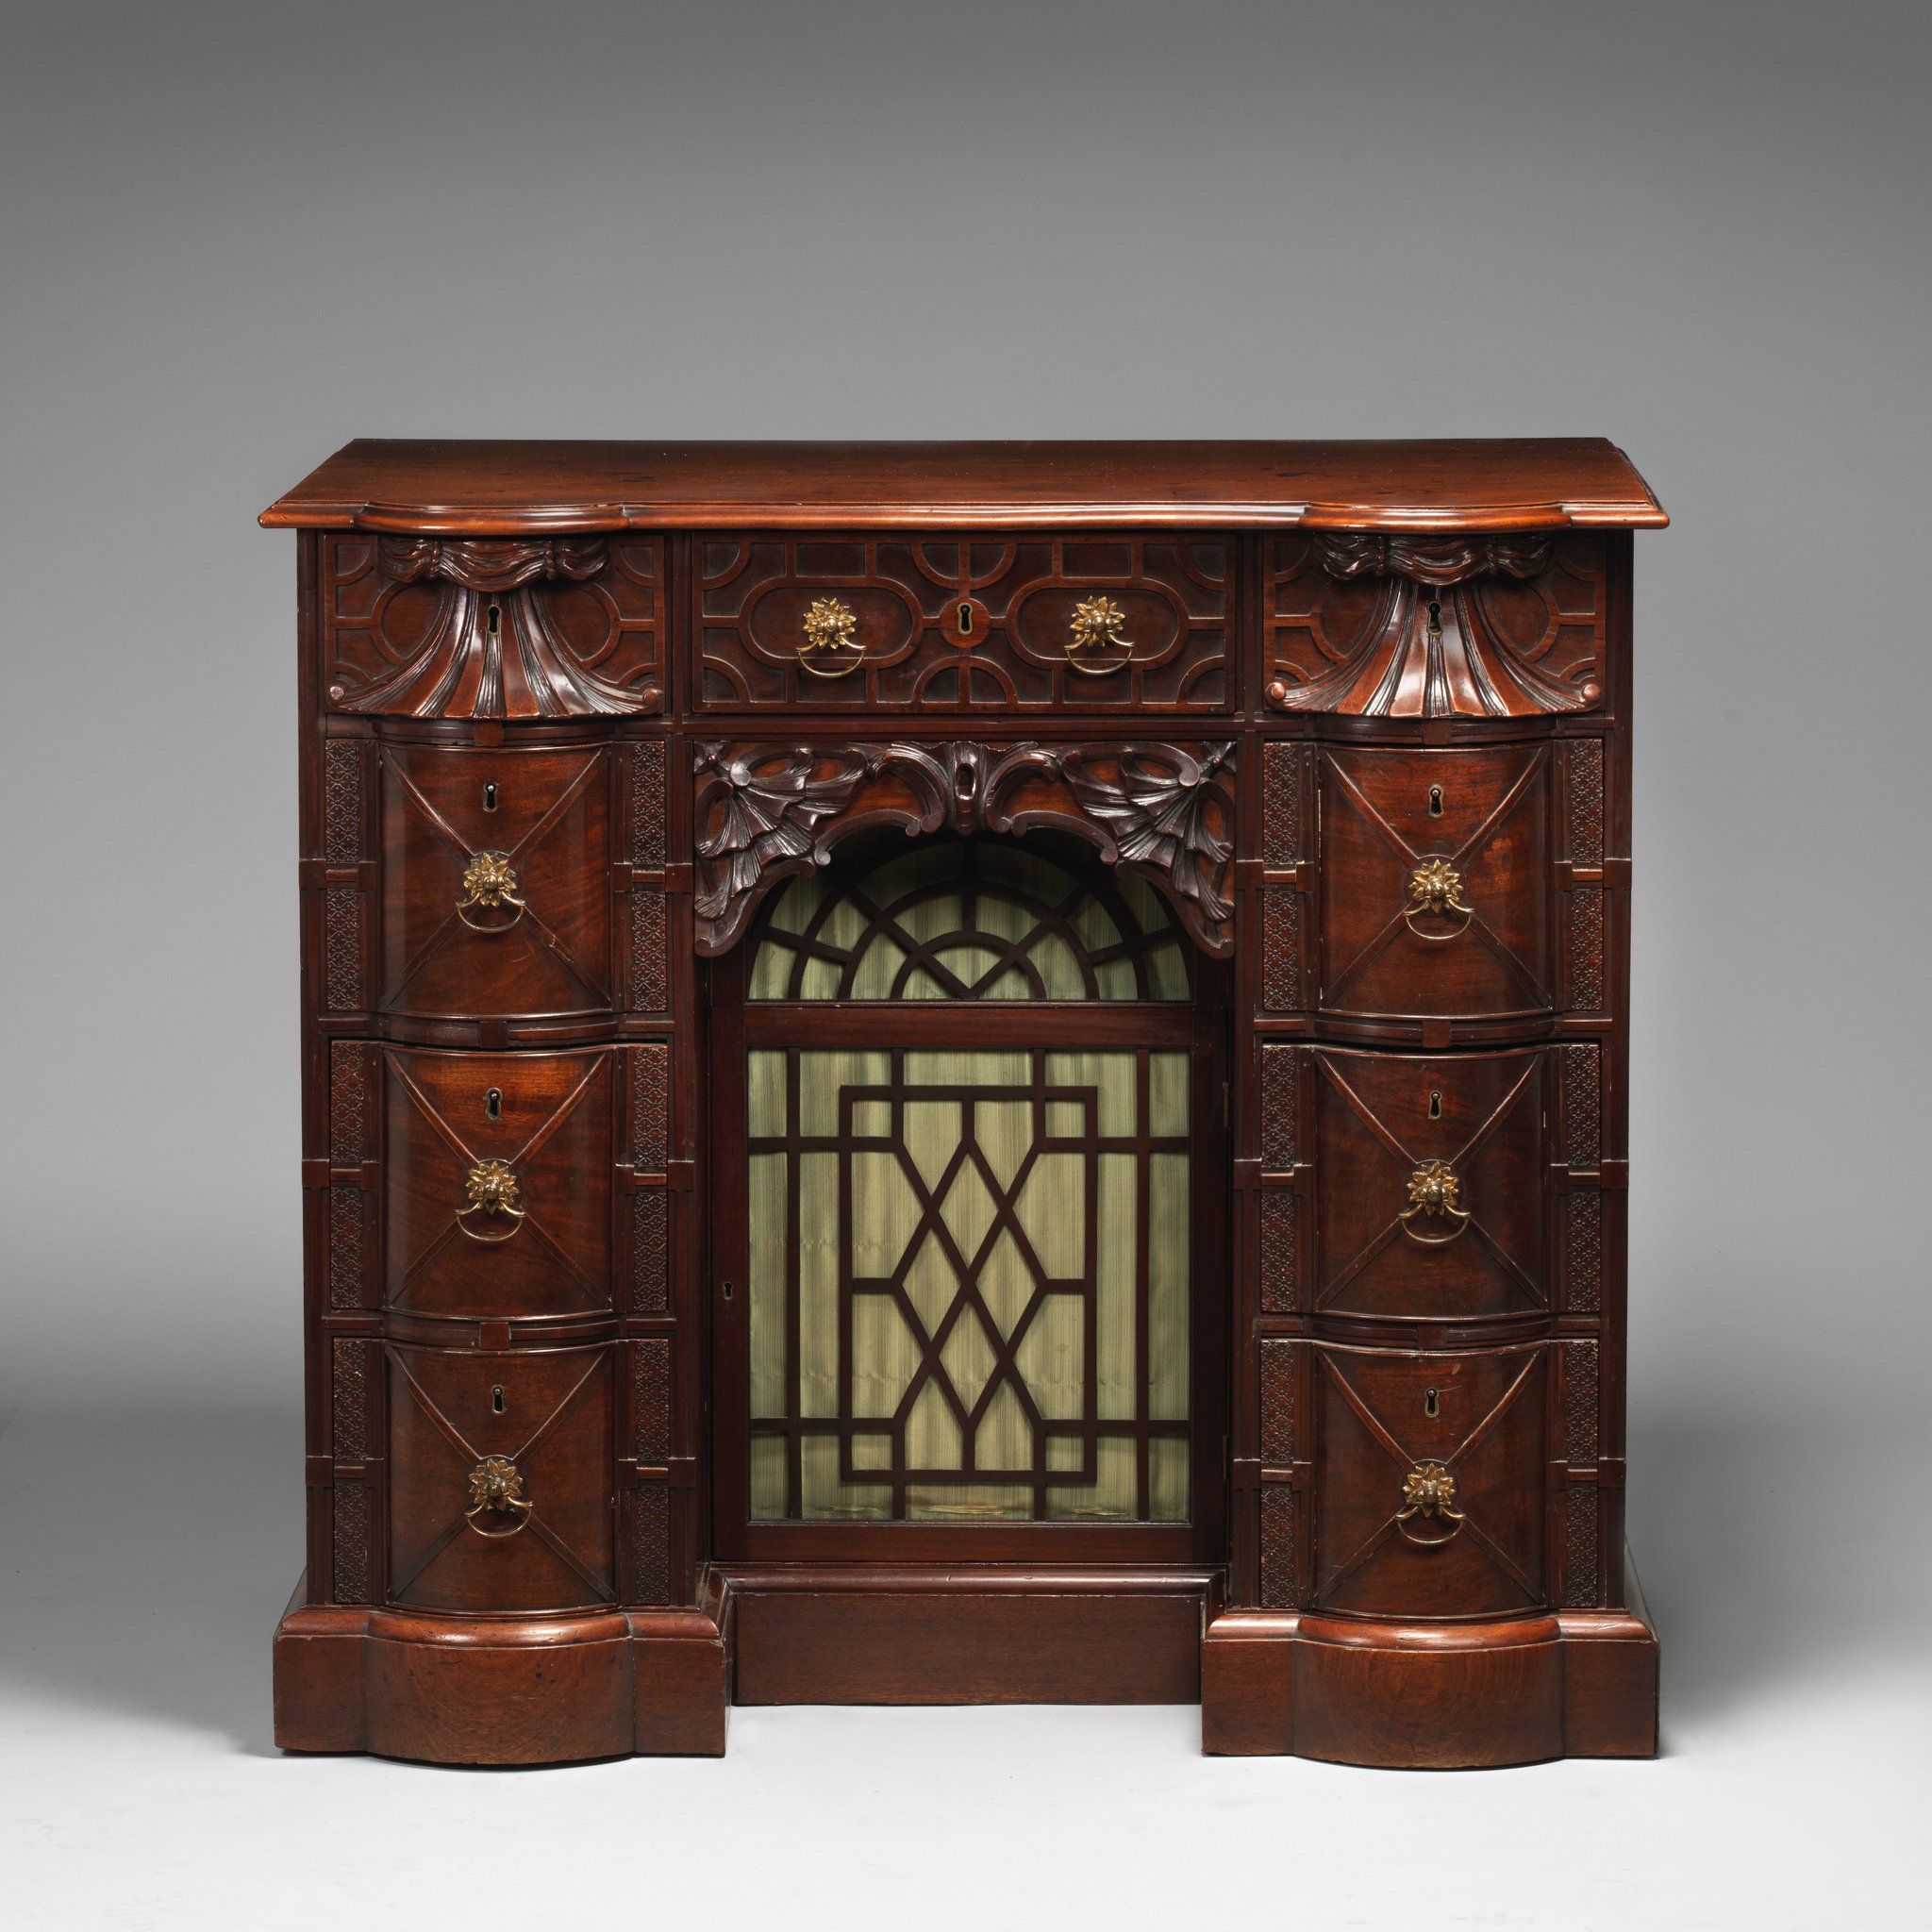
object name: kneehole writing table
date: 1760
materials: gilt bronze, wood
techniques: veneering